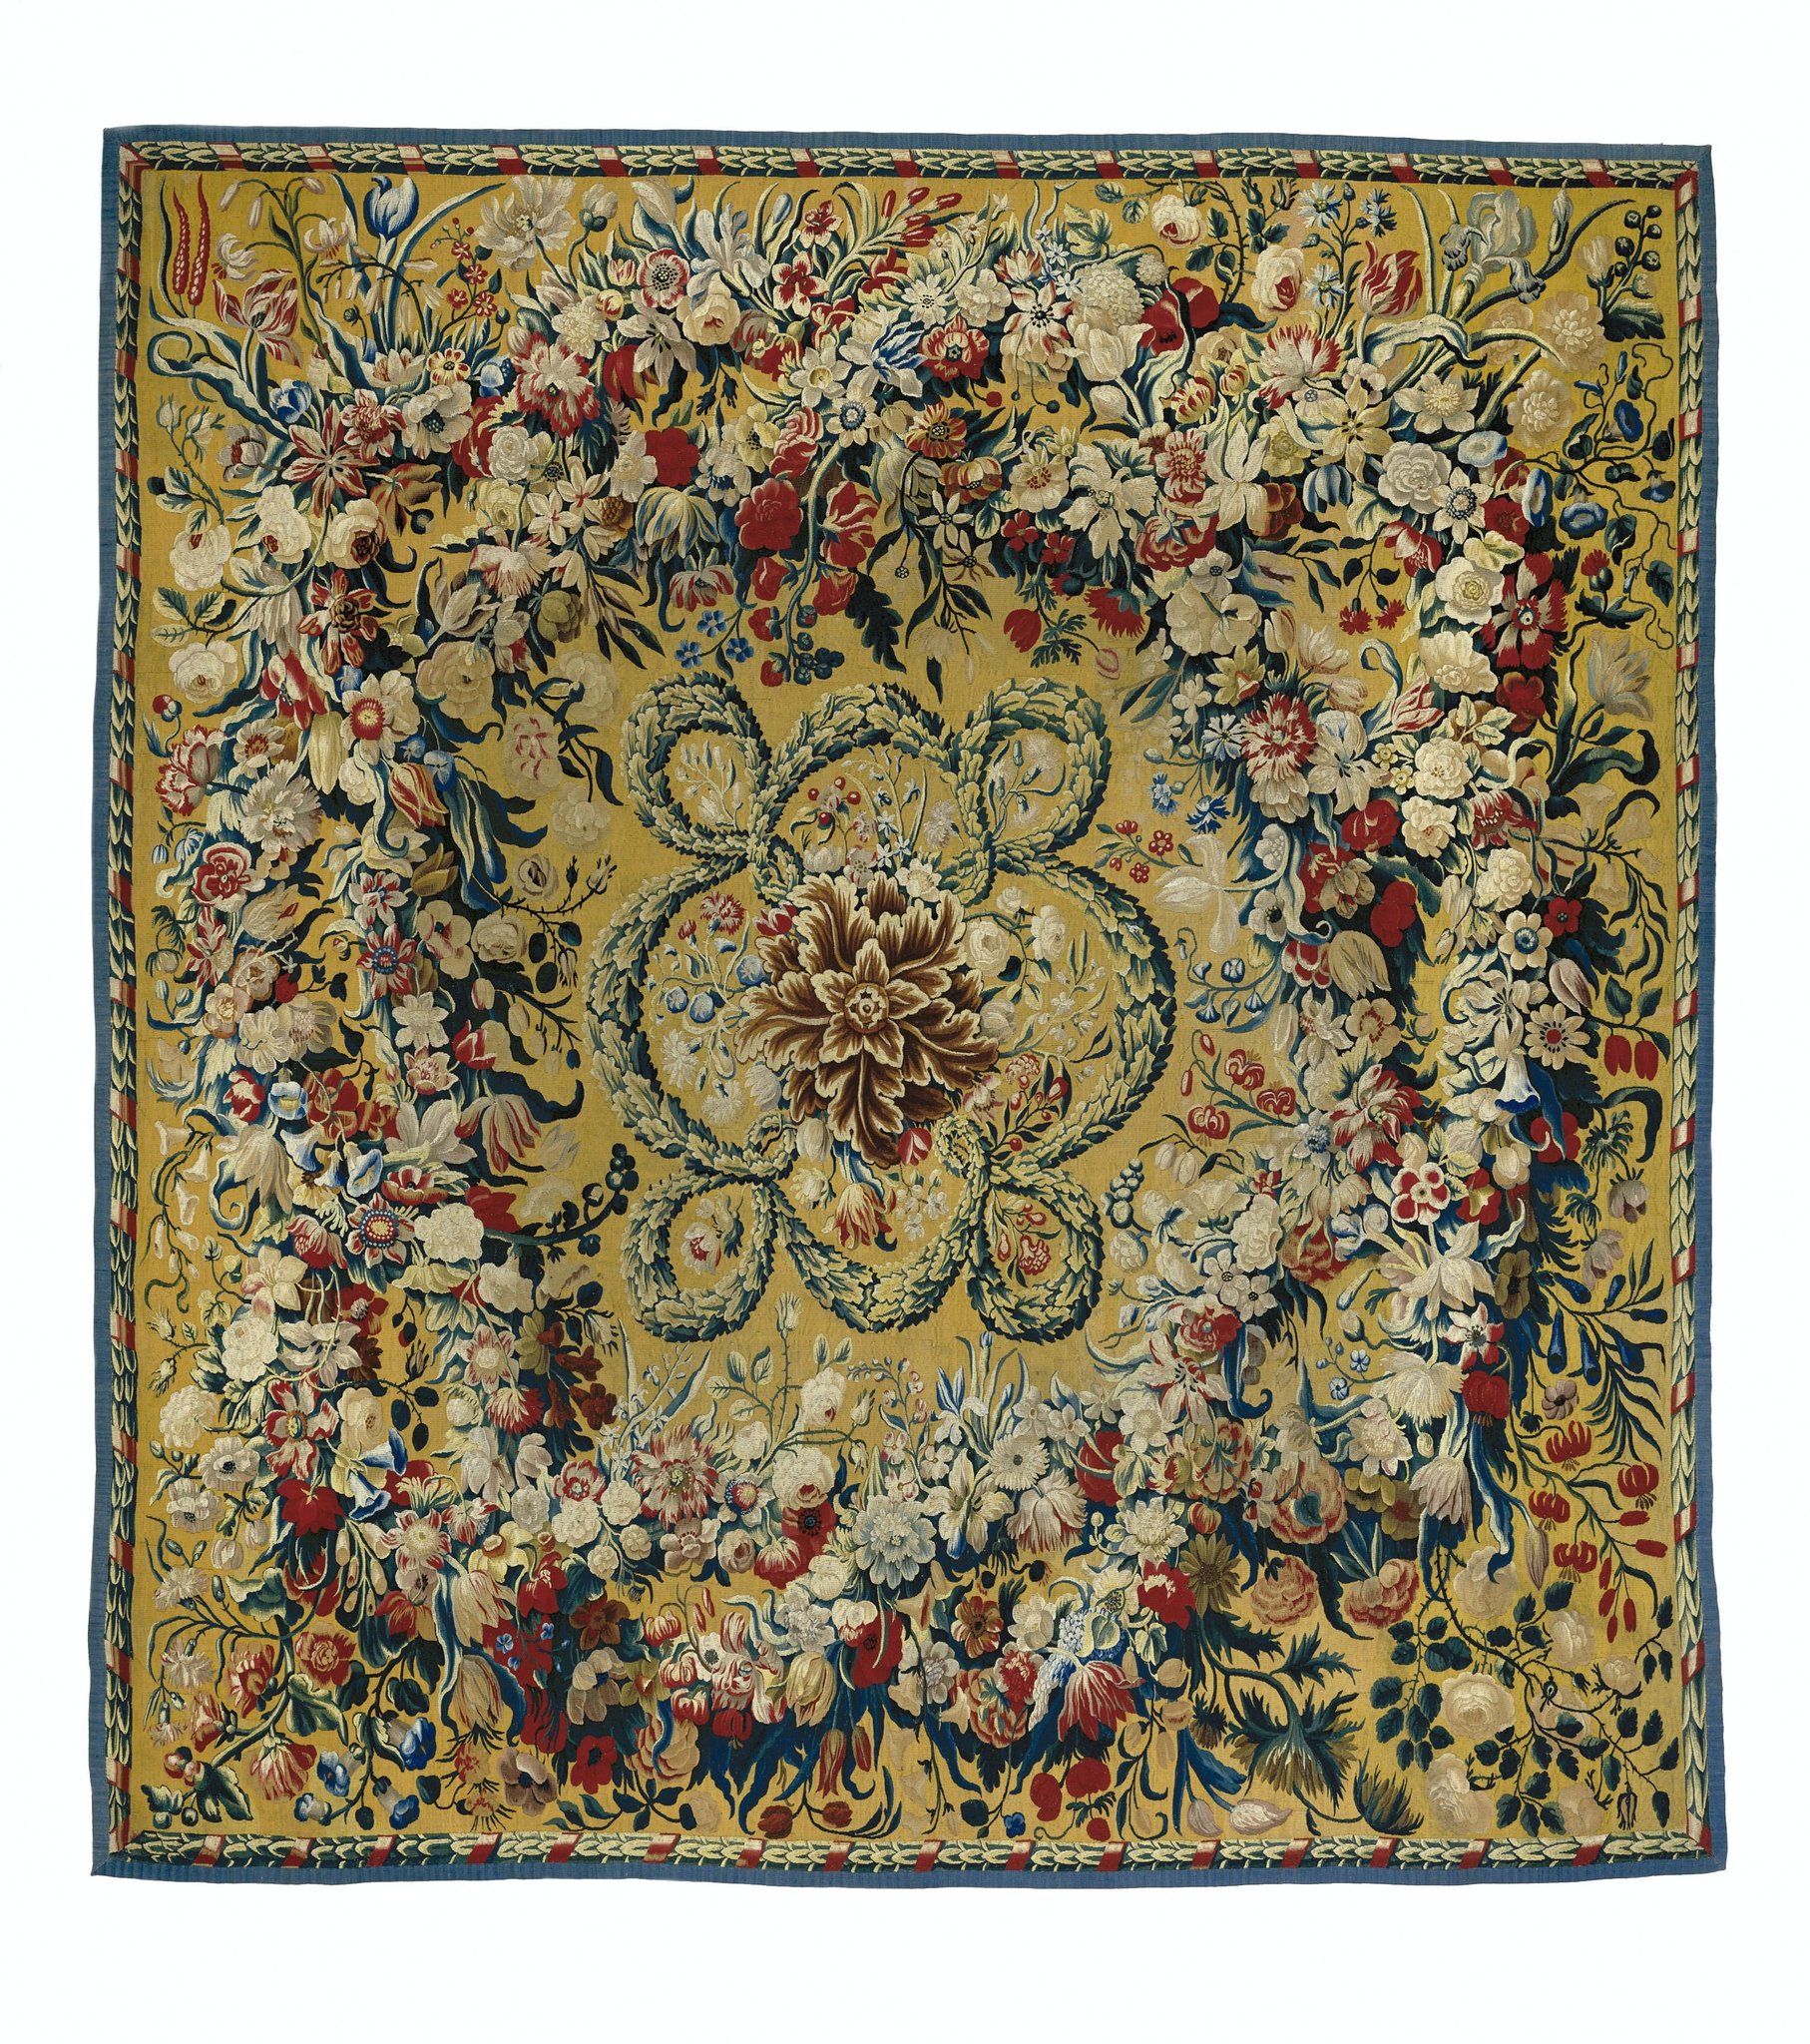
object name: tafelkleed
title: Tapijt met bloemguirlandes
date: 1660-1690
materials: silk, wool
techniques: tapestry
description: Tapisserie met bloemkrans - een tafelkleed of de binnenkant van een hemel van een hemelbed. Op een cadmiumgeel fond staat een eikenbladkrans, waarbinnen bloemen. Hieromheen slingerende bloemkransen.